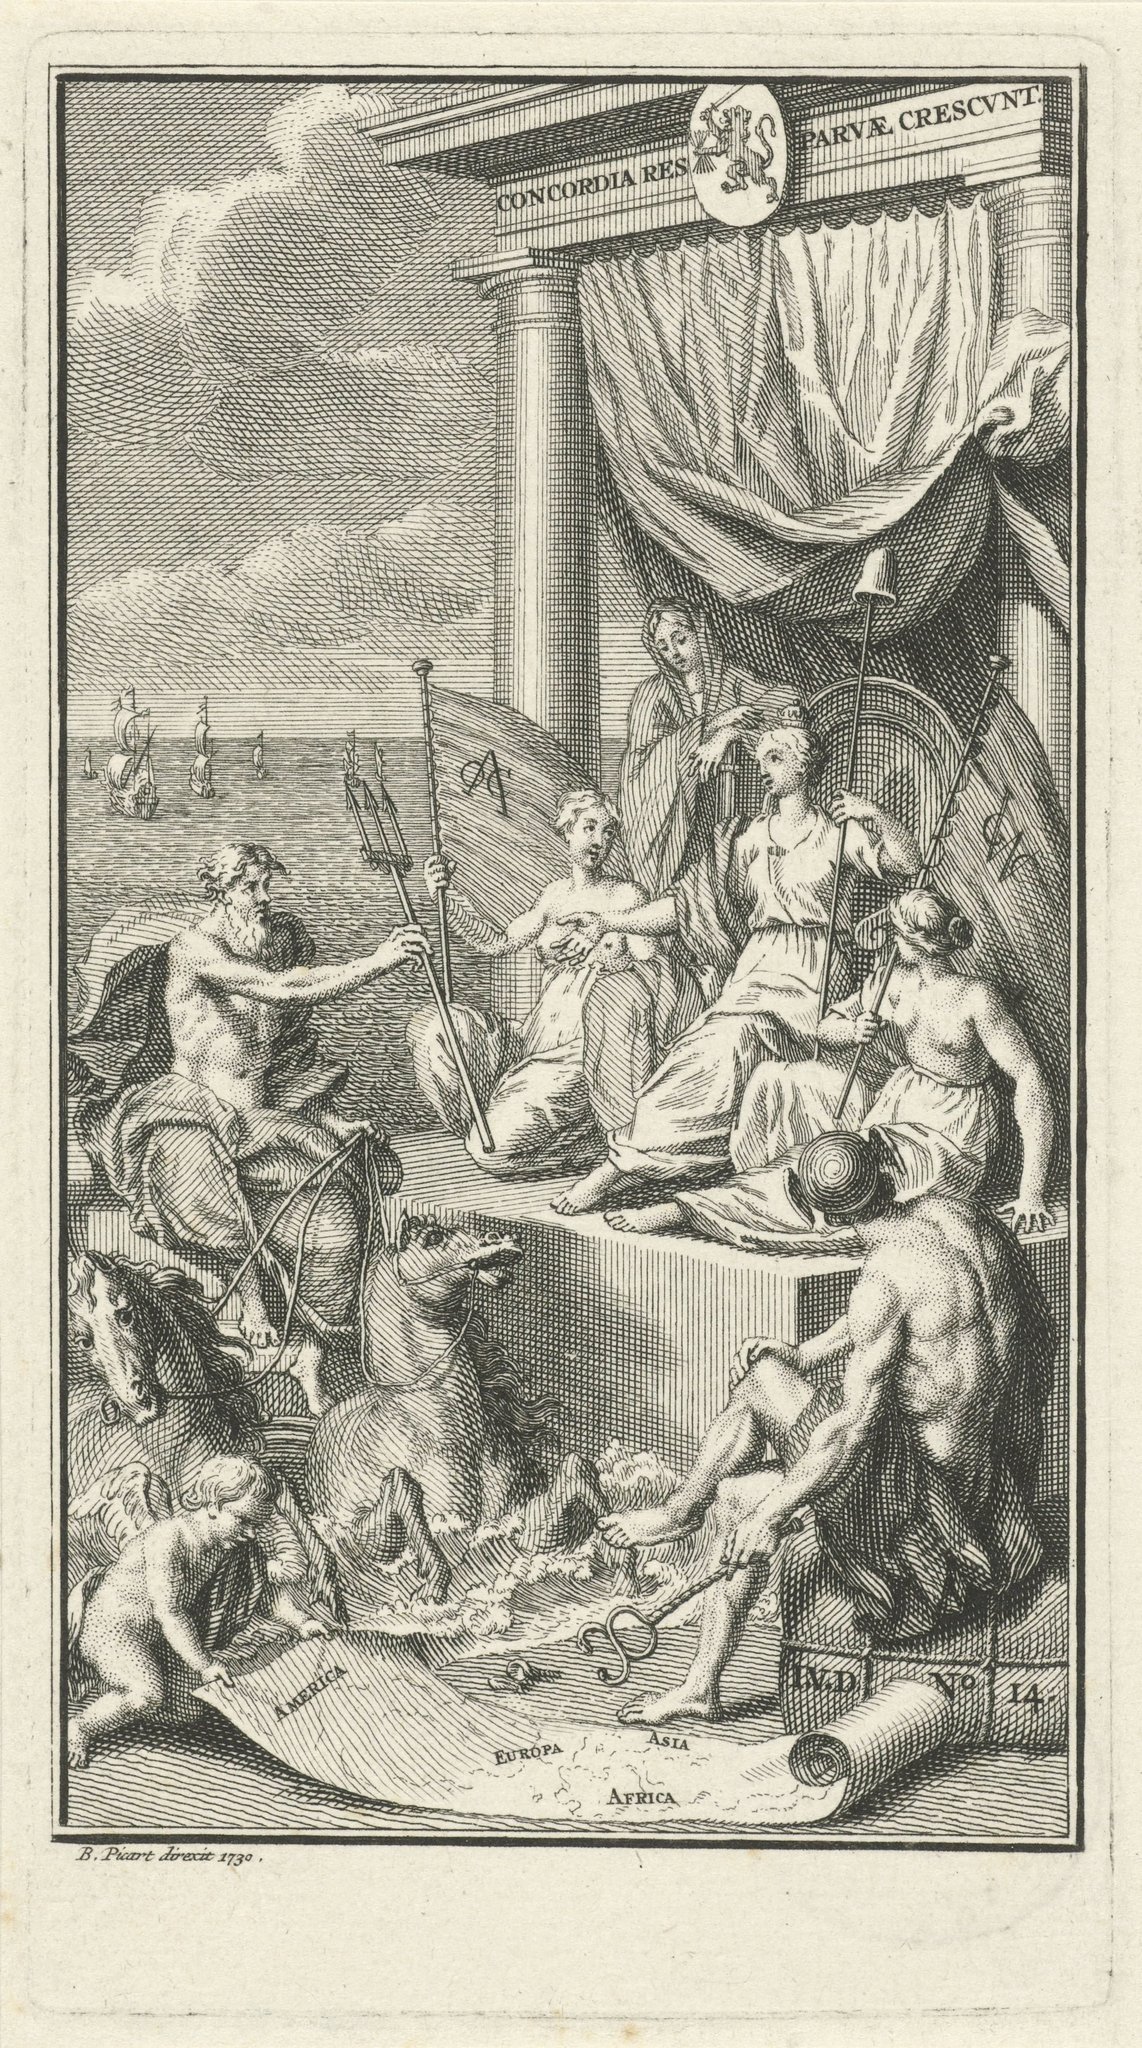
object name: print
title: Titelprent voor: F.M. Janiçon, État présent de la république des Provinces-Unies, 1729-1730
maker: bernard picart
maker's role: draughtsman, print maker, publisher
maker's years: 1673-1733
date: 1730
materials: paper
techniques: engraving, etching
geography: amsterdam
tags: (story of) neptune (poseidon), faith, 'fides'; 'fede', 'fede catholica', 'fede christiana', 'fede christiana catholica' (ripa) ~ one of the three theological virtues, personifications of countries, nations, states, districts, etc., (story of) mercury (hermes), map of the world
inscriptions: collector's mark: Lugt 240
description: Neptunus schenkt zijn drietand, die symbool staat voor de overheersing op de wereldzeeën, aan de personificatie van de Republiek der Zeven Verenigde Nederlanden. Zij houdt in de hand een lans met vrijheidshoed en wordt omringd door de personificaties van de Oost-Indische Compagnie (VOC) en de West-Indische Compagnie (WIC). Rechts wijst Mercurius met zijn caduceus op de wereldkaart die door een putto wordt uitgerold. Met een lege marge.